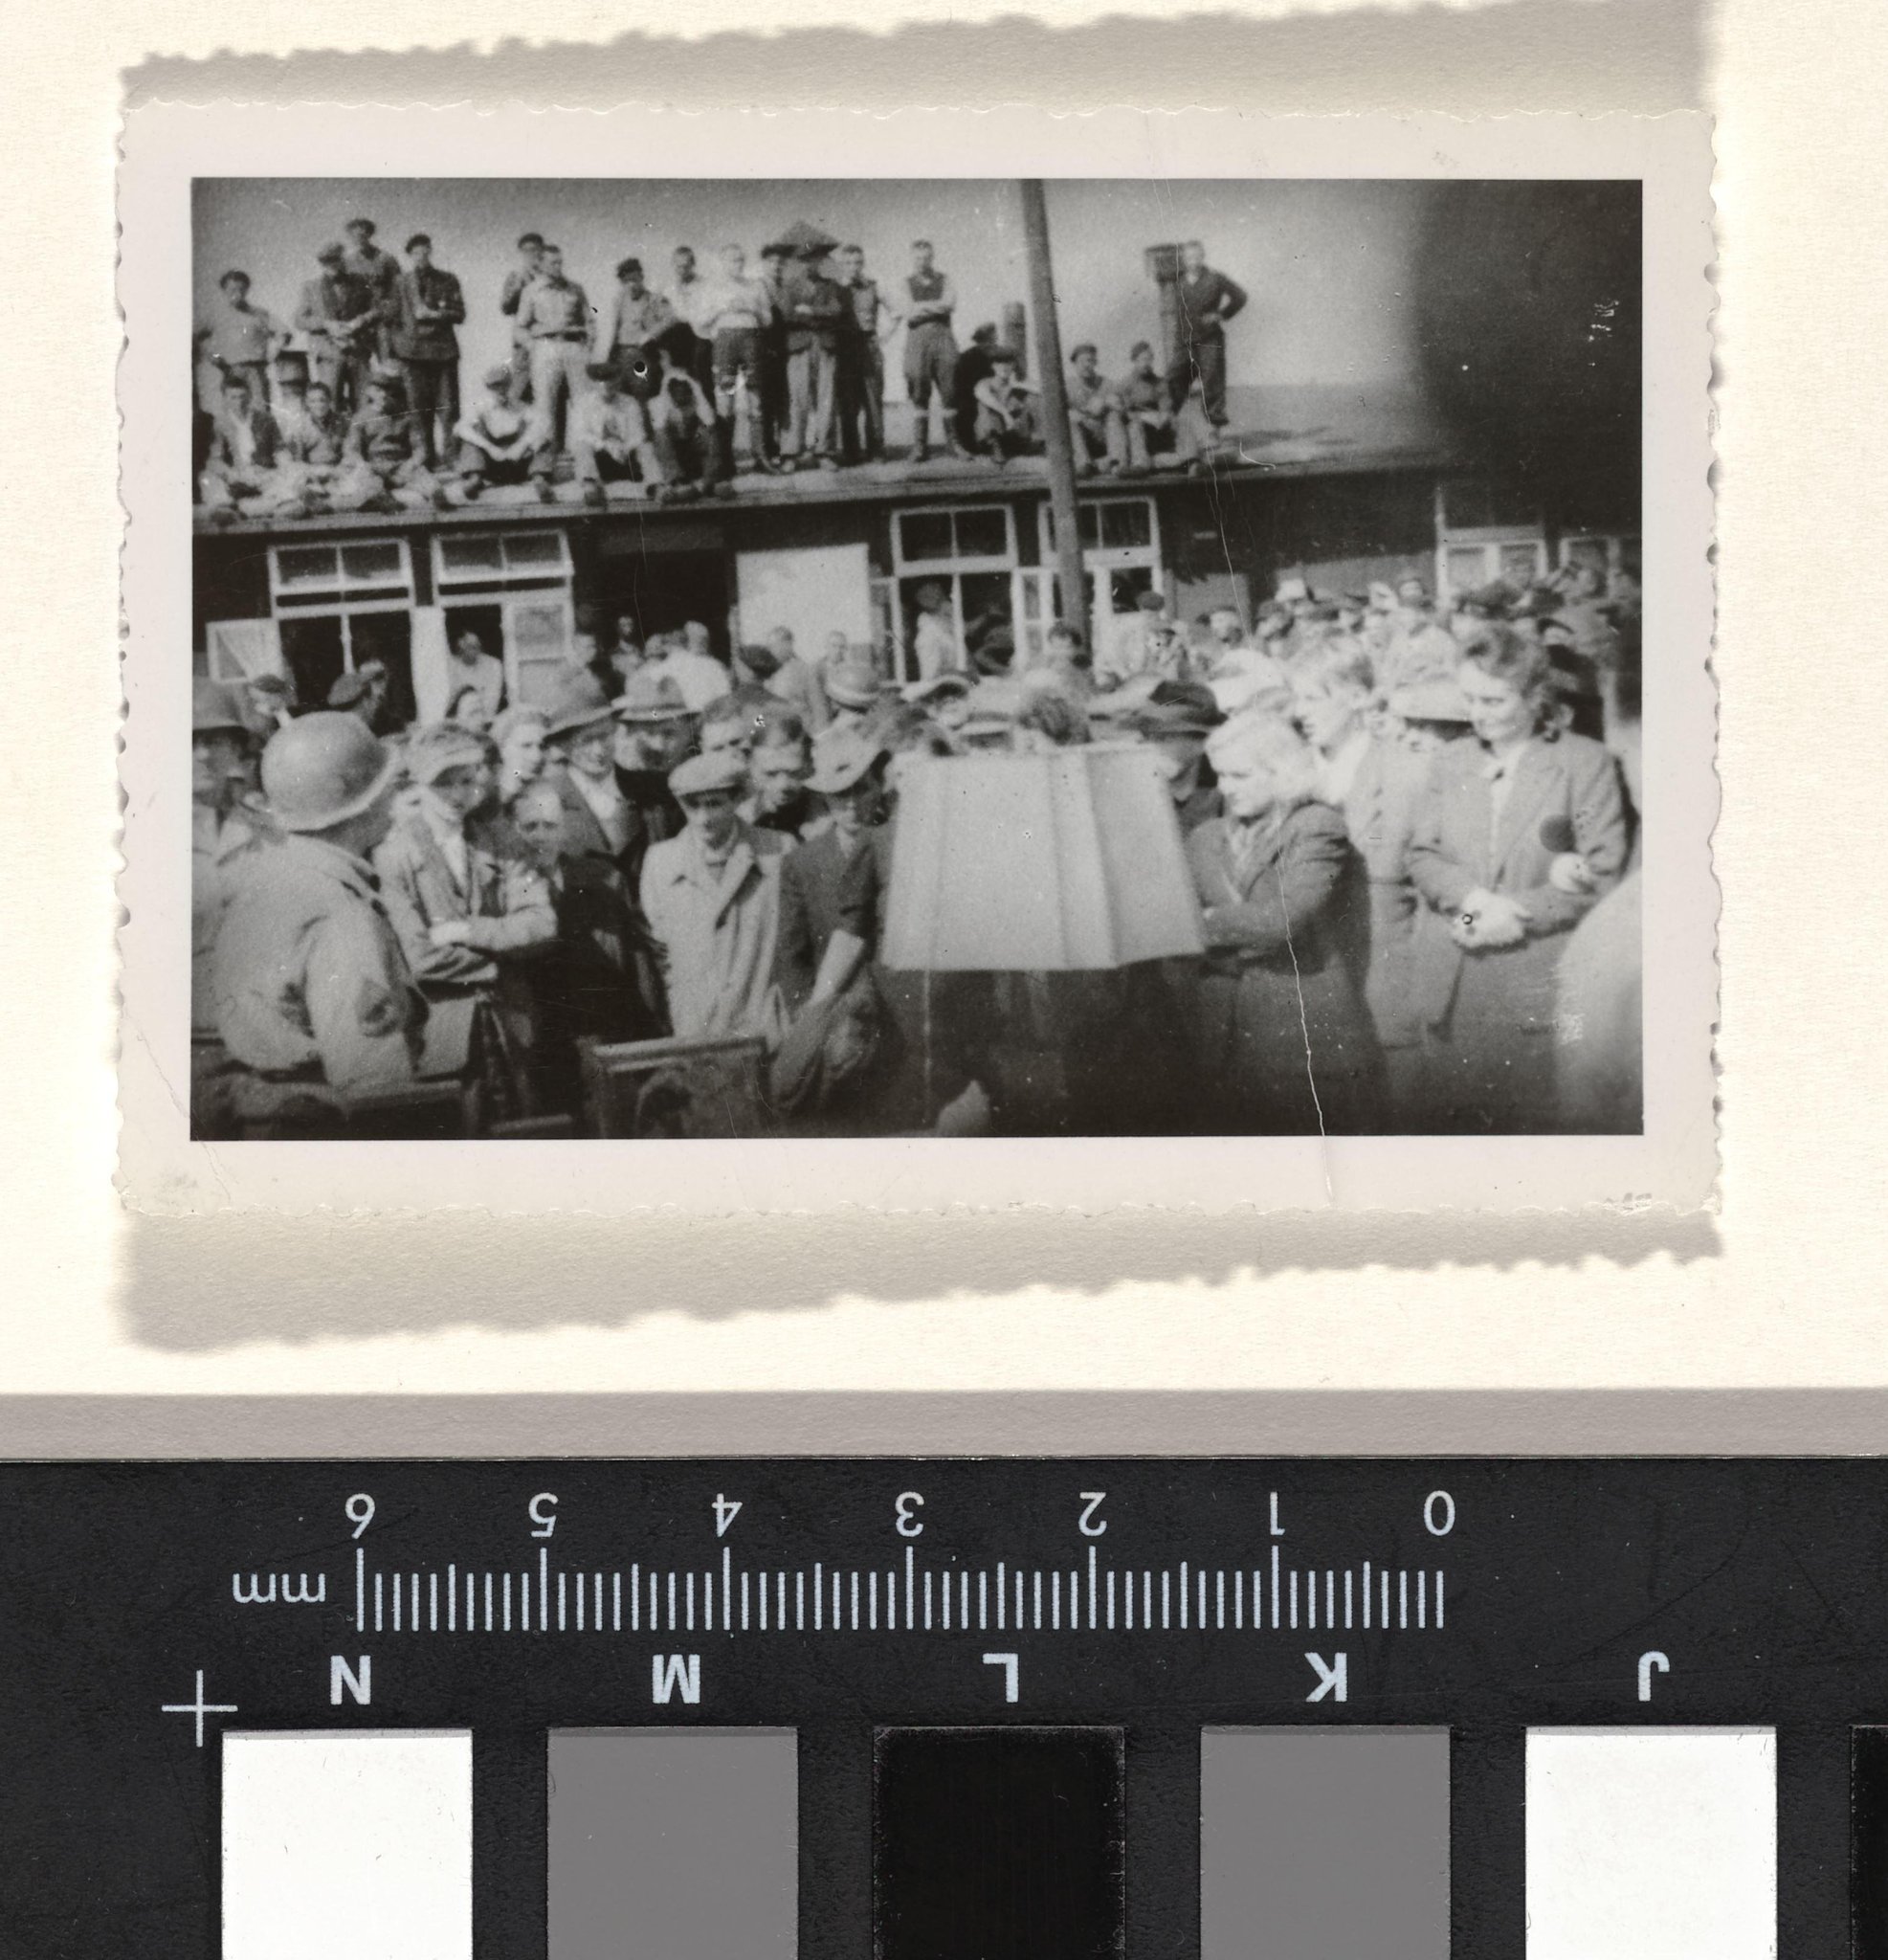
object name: photograph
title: Onbekende voormalige gevangenen en Amerikaanse soldaten, april 1945?, concentratiekamp Buchenwald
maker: Anonymous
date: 1904-1945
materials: photographic support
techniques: gelatin silver print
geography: buchenwald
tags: buchenwald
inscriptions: inscription: ‘K.Z. Buchenwald’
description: Onbekende voormalige gevangenen en Amerikaanse soldaten, april 1945?, concentratiekamp Buchenwald.